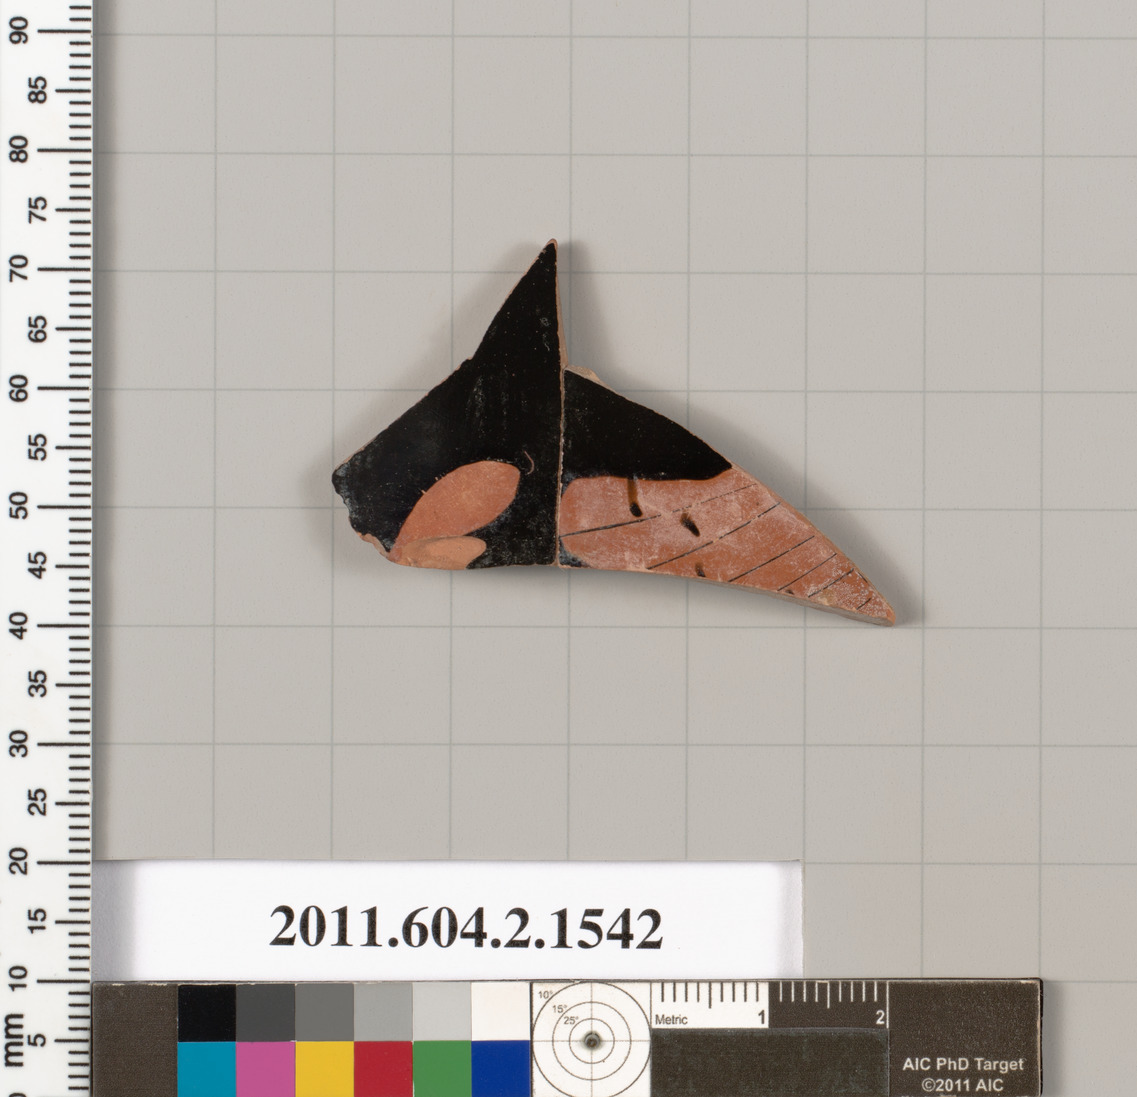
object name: skyphos fragment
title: Terracotta fragment of a skyphos (deep drinking cup)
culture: greek, attic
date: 425-401 BCE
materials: terracotta